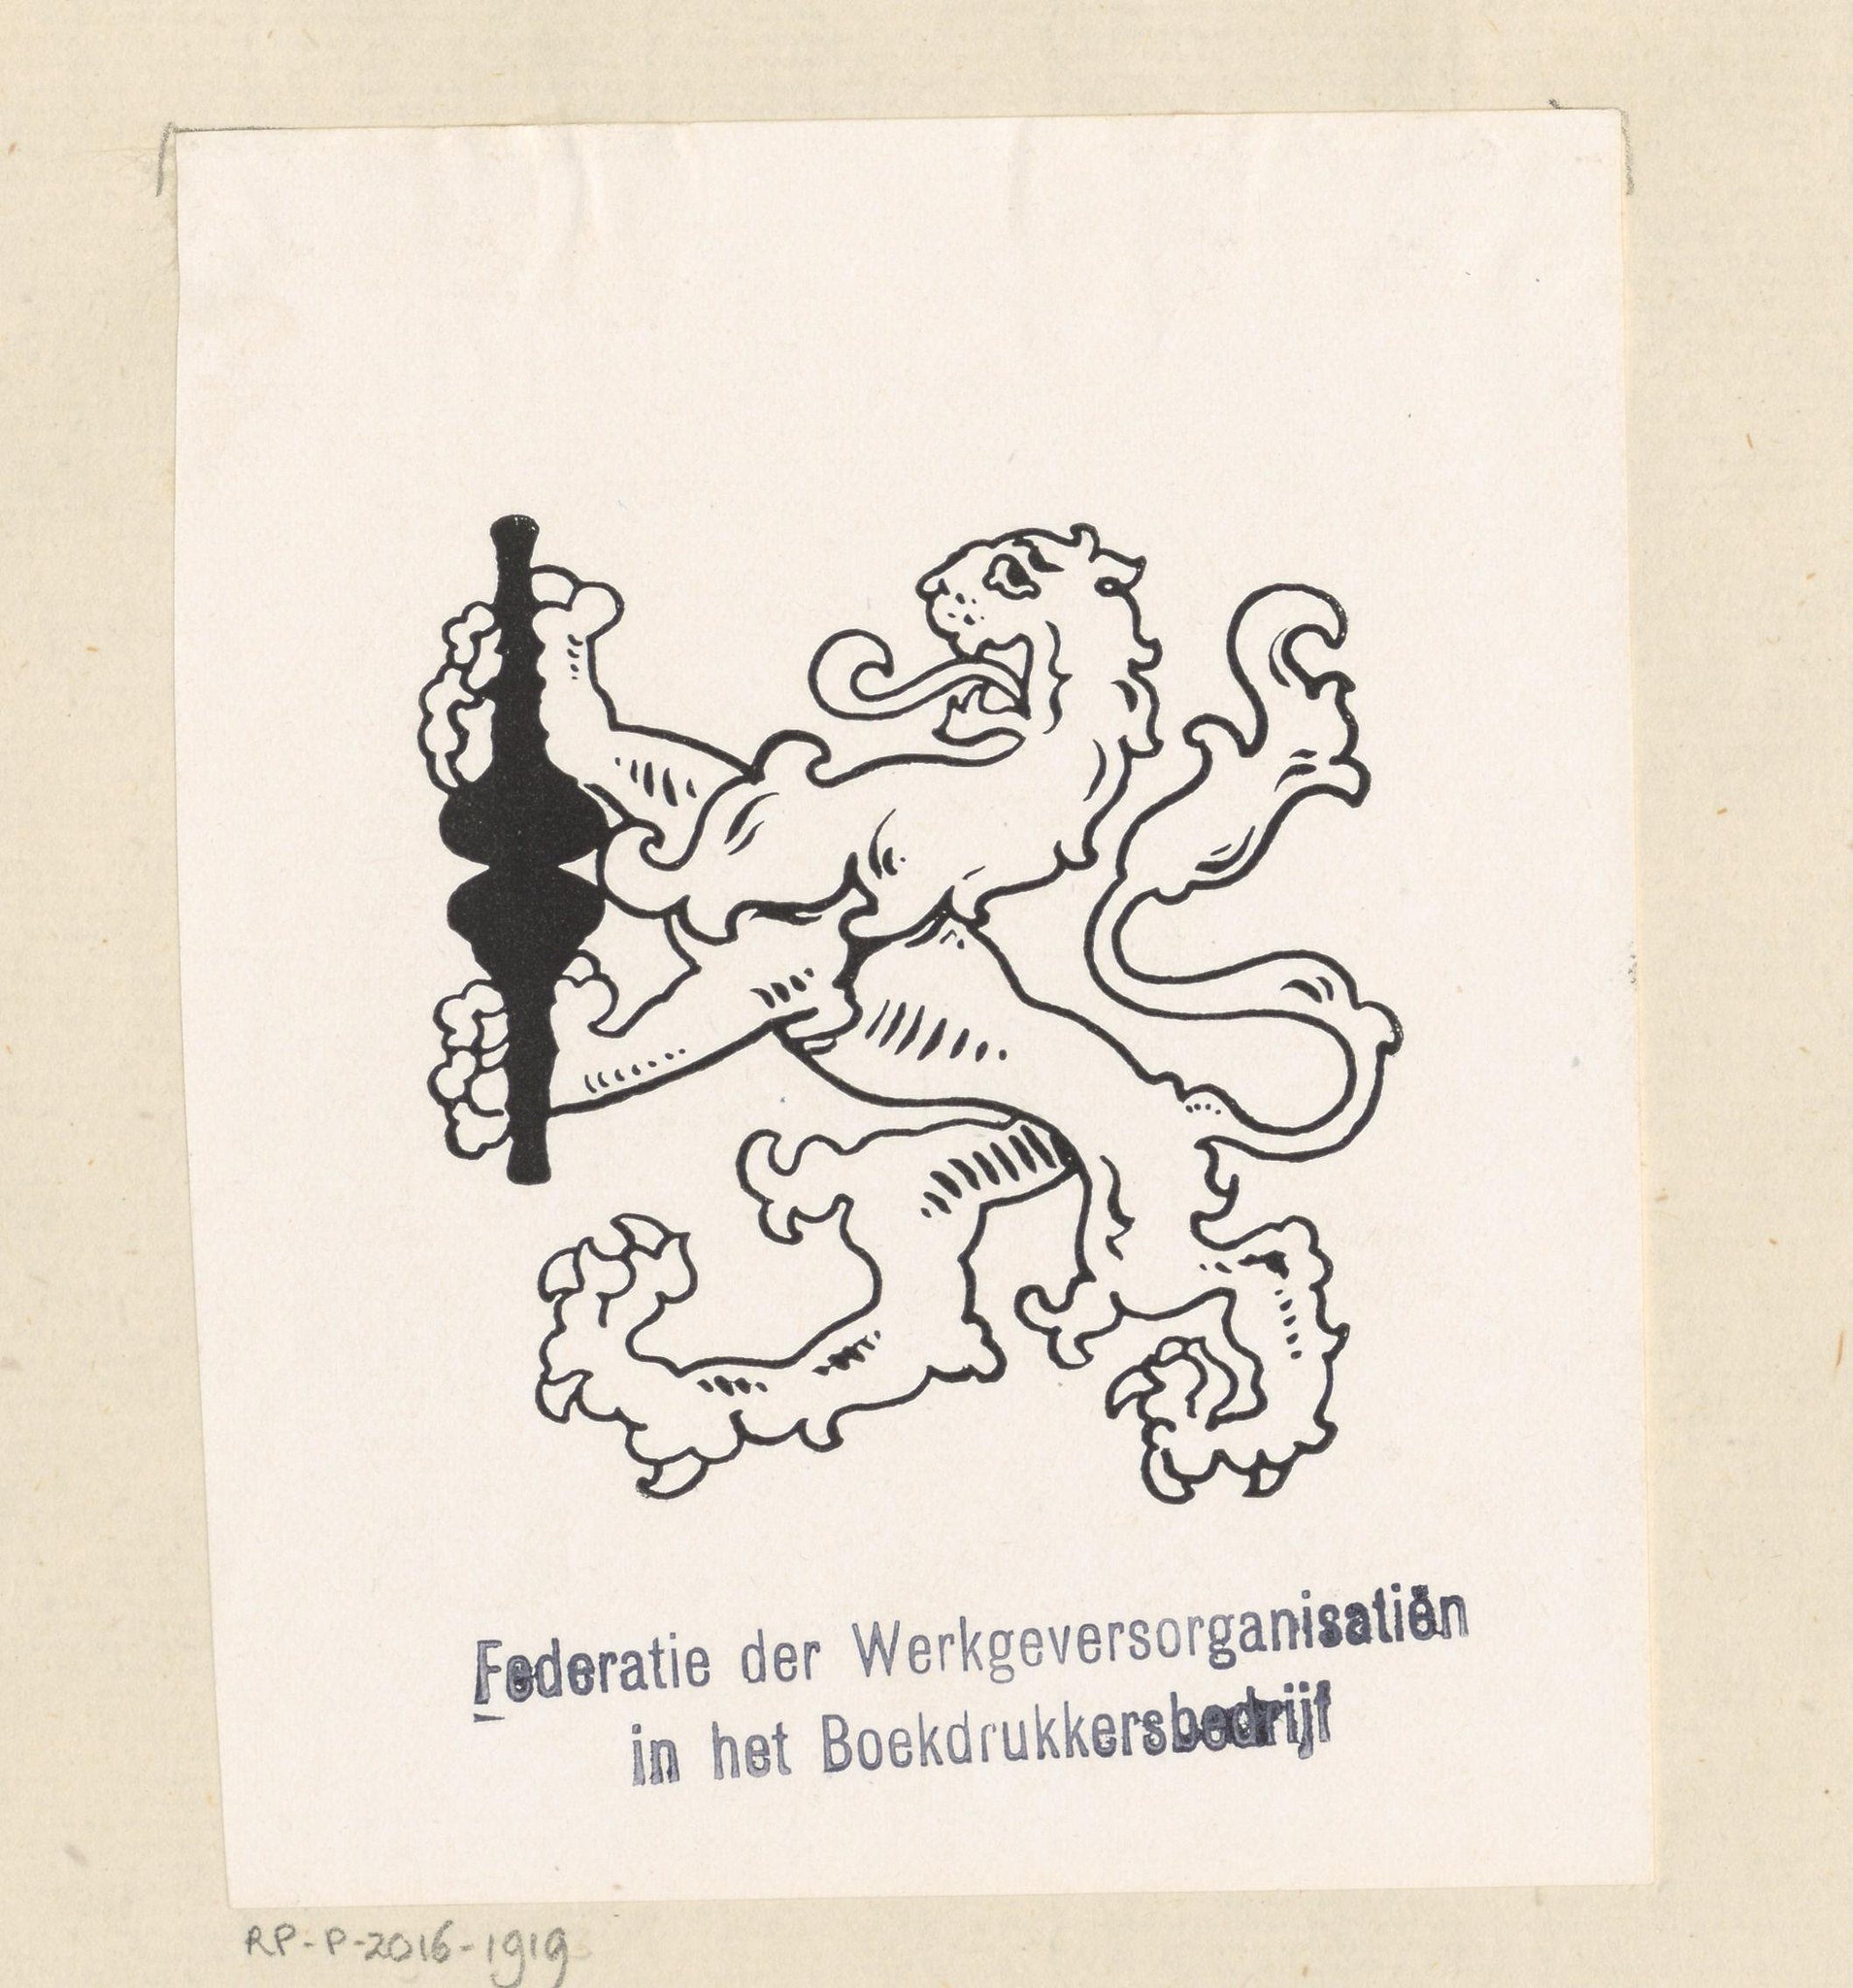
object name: bookplate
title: Ex libris van de Federatie der Werkgeversorganisatiën in het Boekdrukkersbedrijf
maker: Anonymous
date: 1900-1999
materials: paper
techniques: printing block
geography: netherlands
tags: printing ~ applied arts, armorial bearing, heraldry